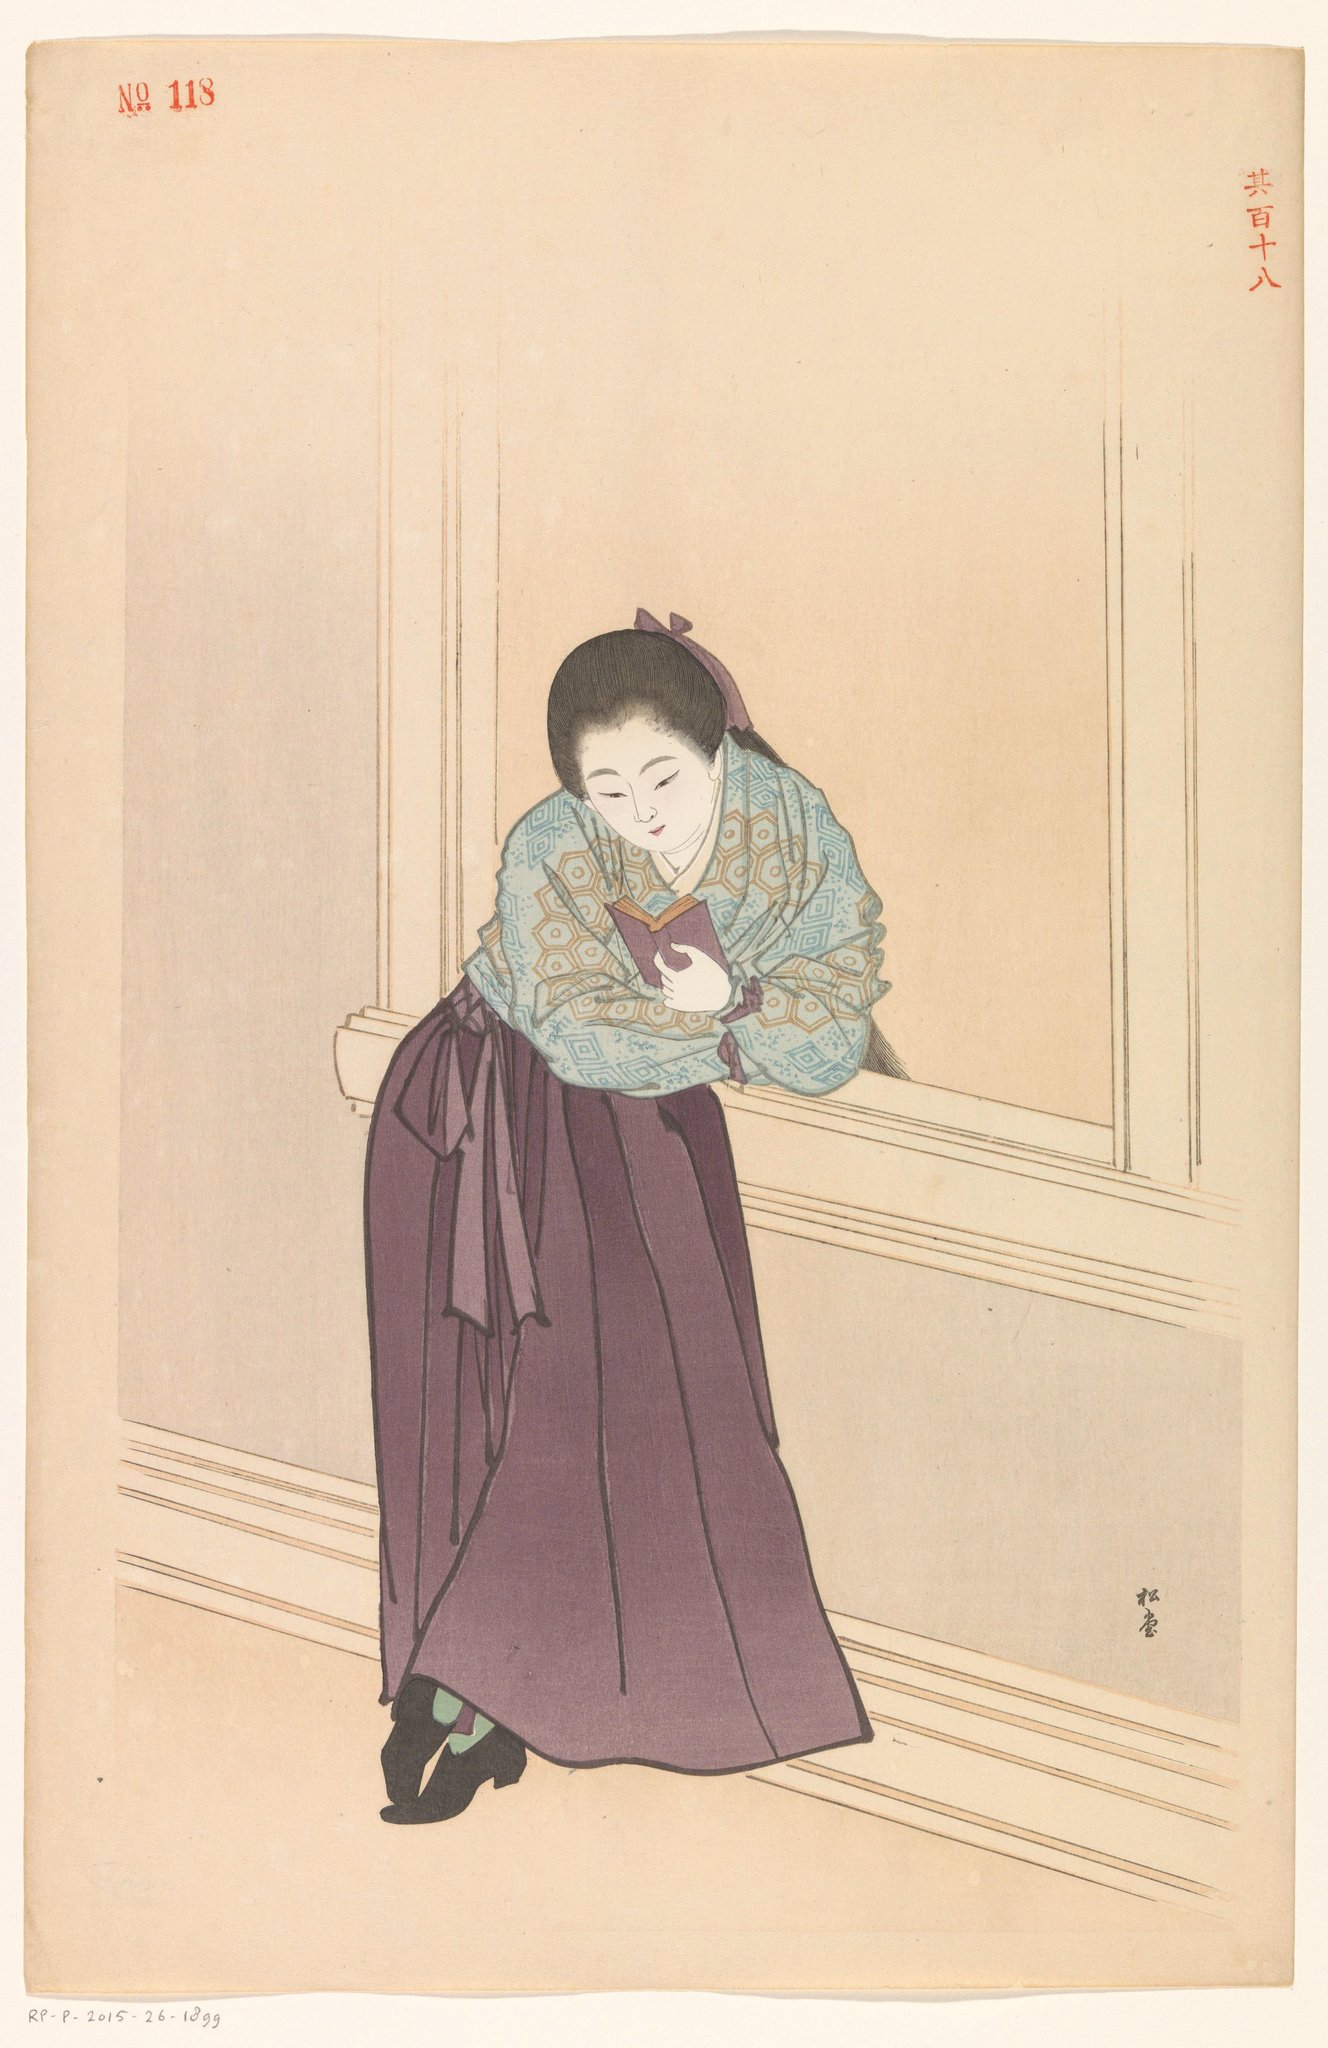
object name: print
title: Lezende vrouw voor een venster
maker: shodo yukawa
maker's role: print maker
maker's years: 1868-1955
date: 1900-1925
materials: paper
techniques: woodcut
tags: reading, book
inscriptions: collector's mark: Lugt 2228